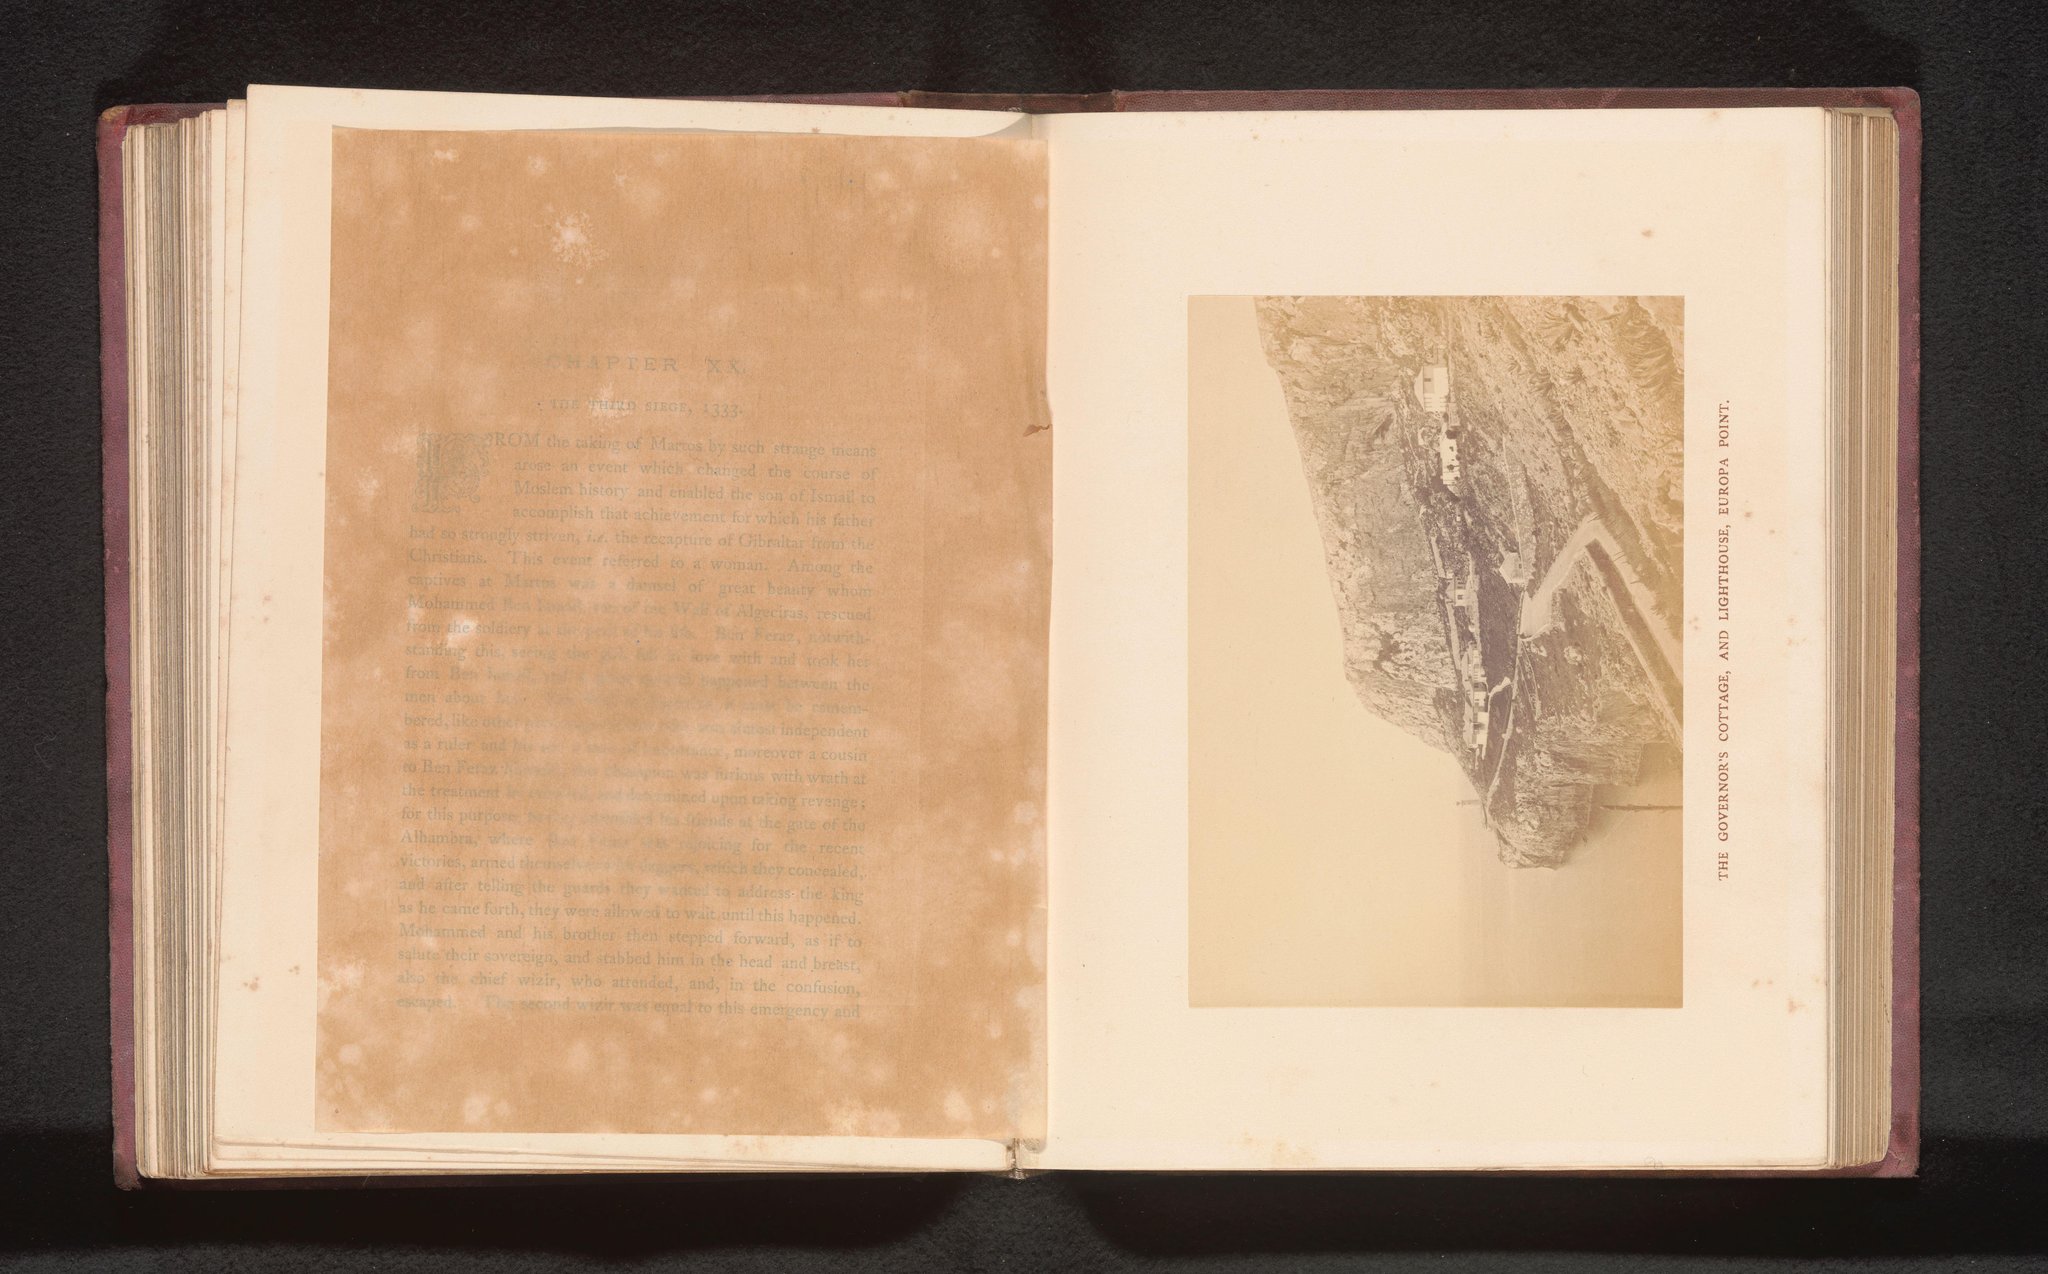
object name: photograph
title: The governor's cottage, and lighthouse, Europa point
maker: j.h. mann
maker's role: fotograaf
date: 1860-1870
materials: photographic support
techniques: albumen print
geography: gibraltar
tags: lighthouse, lightship, rocky coast